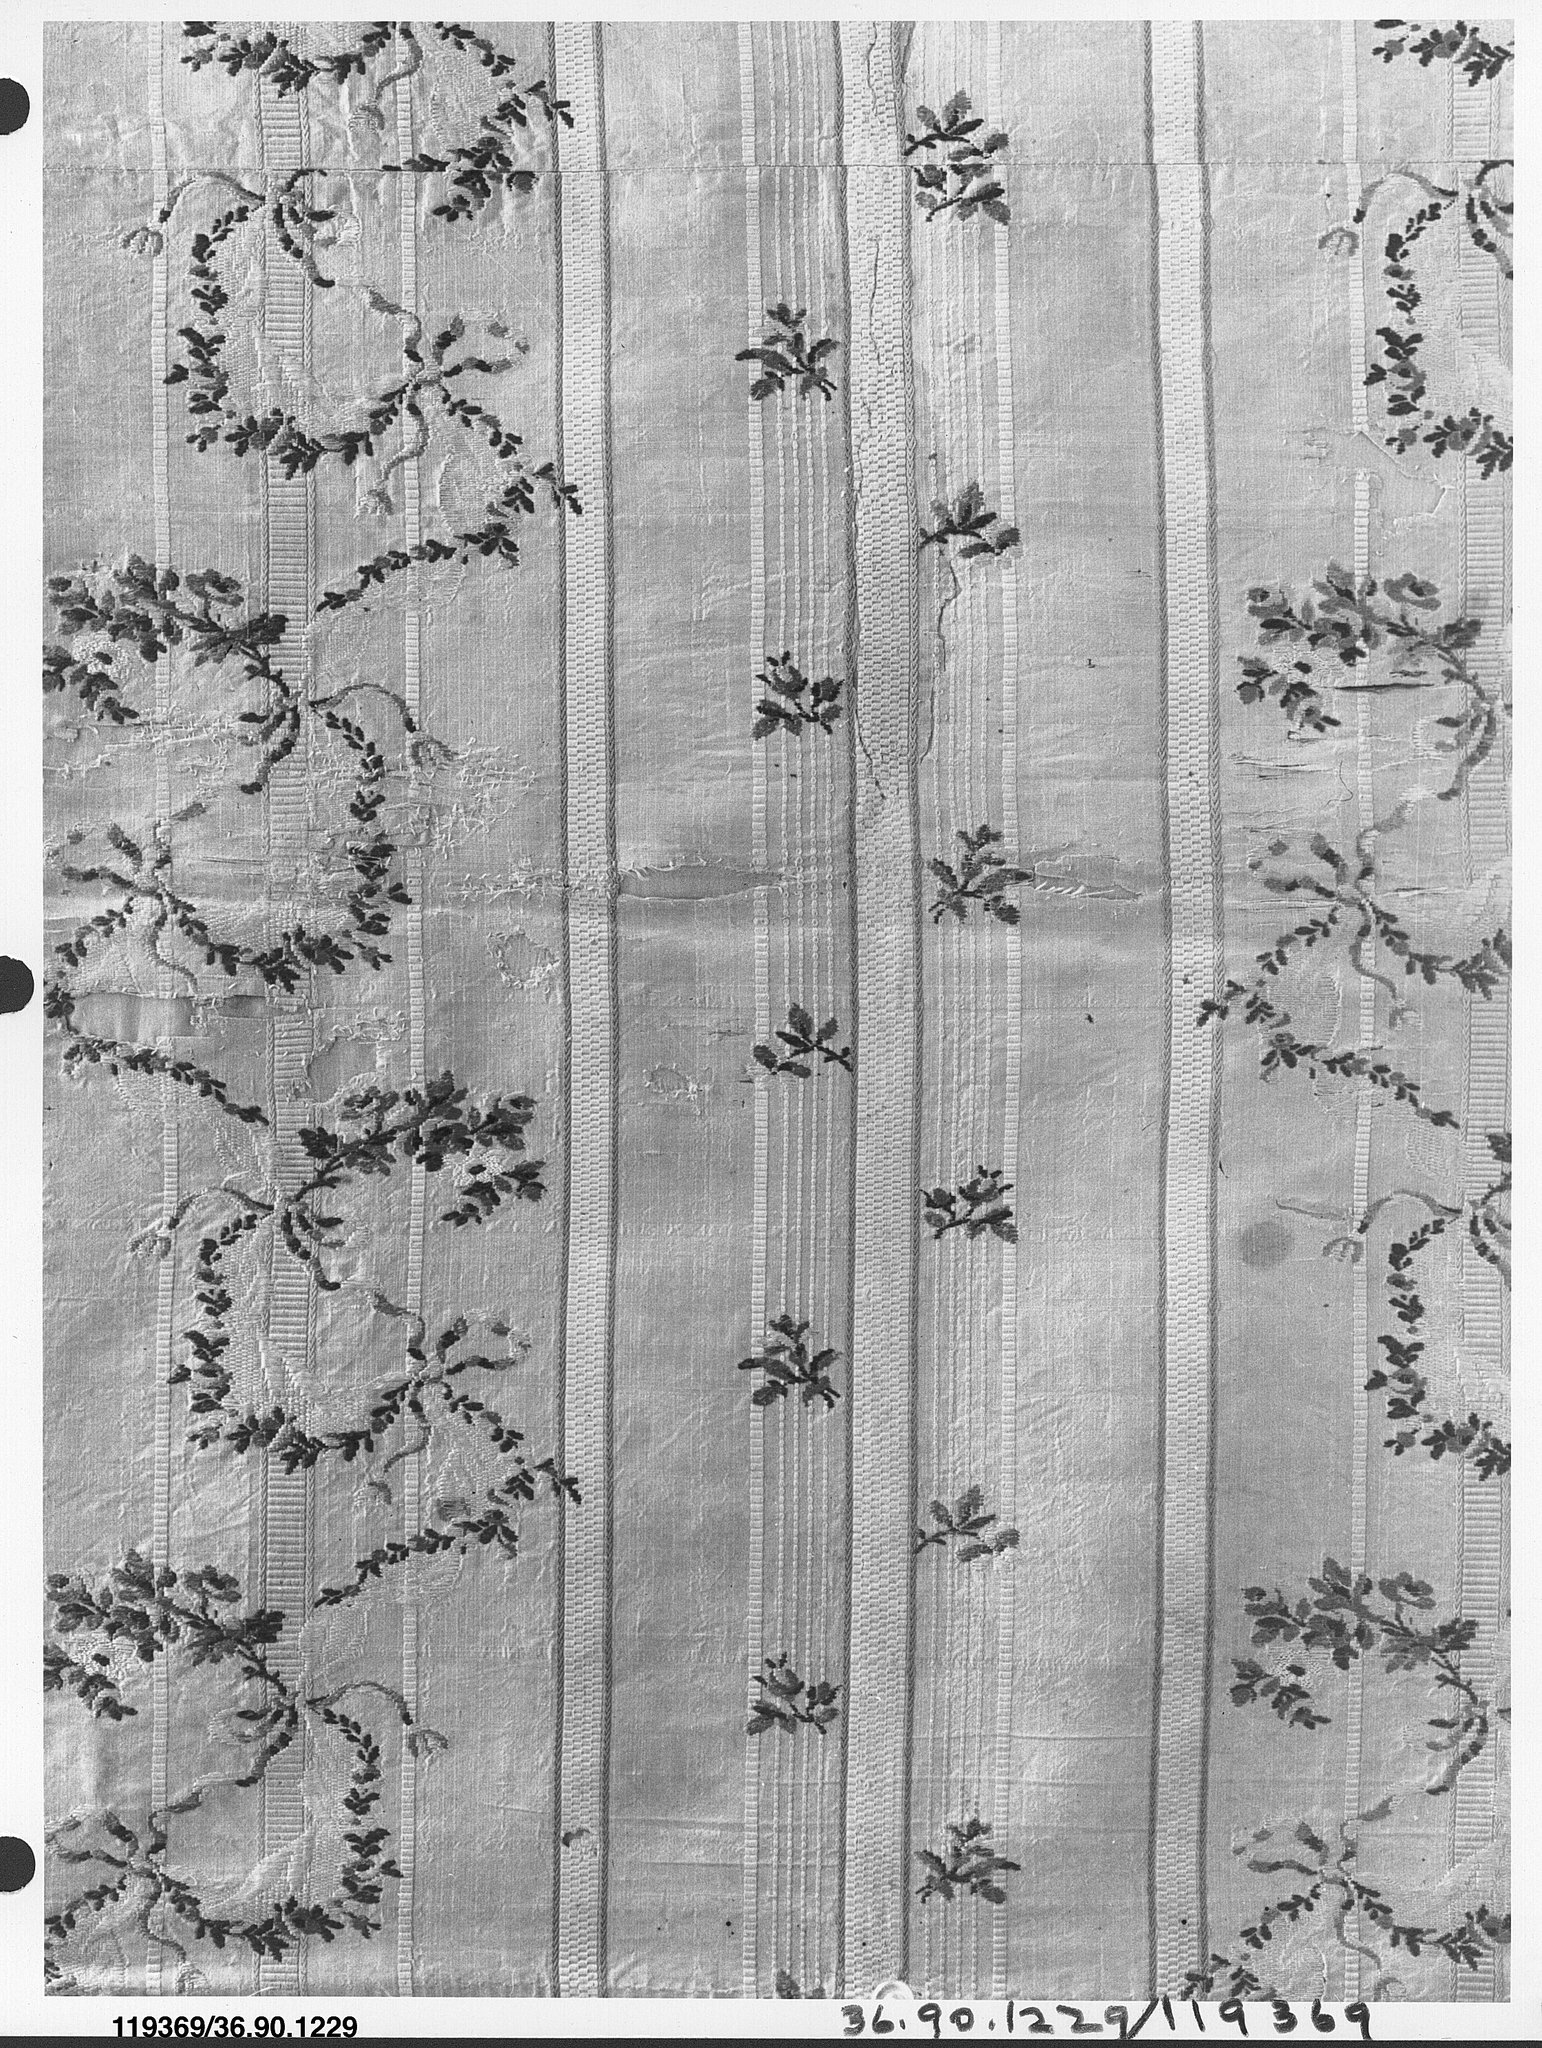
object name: piece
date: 1701-1800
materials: silk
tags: flowers,leaves